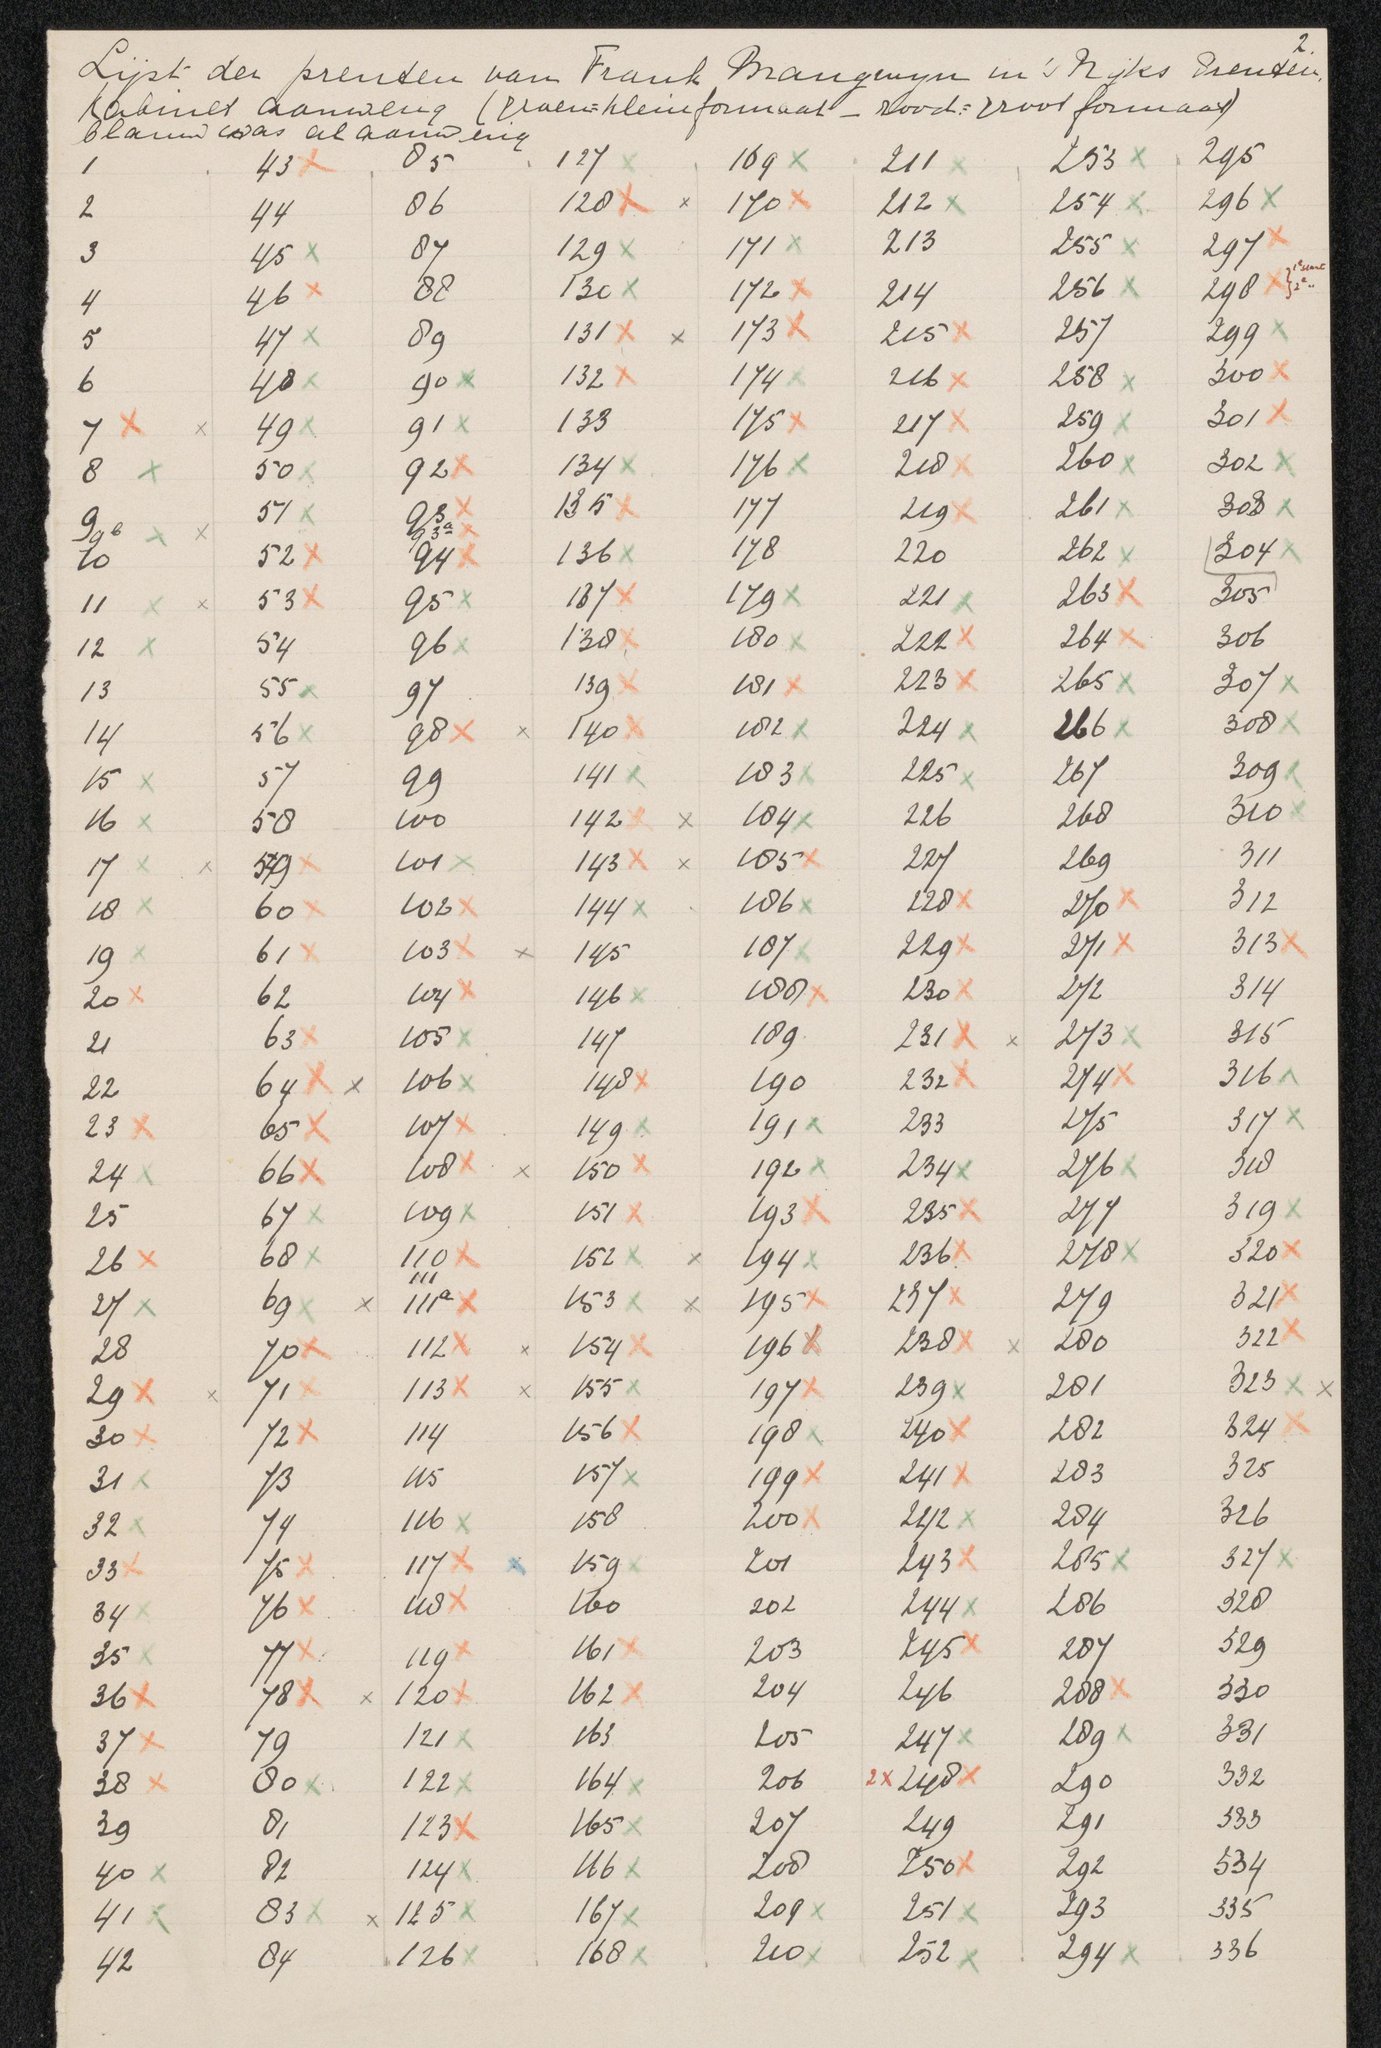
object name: document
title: Lijst met prenten van Sir Frank Brangwyn aanwezig in het Rijksprentenkabinet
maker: Anonymous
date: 1931-1932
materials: ink, paper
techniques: pen, writing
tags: print room, bruges, print maker, frank brangwyn (sir), the graphic arts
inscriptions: collector's mark: ‘RPK’